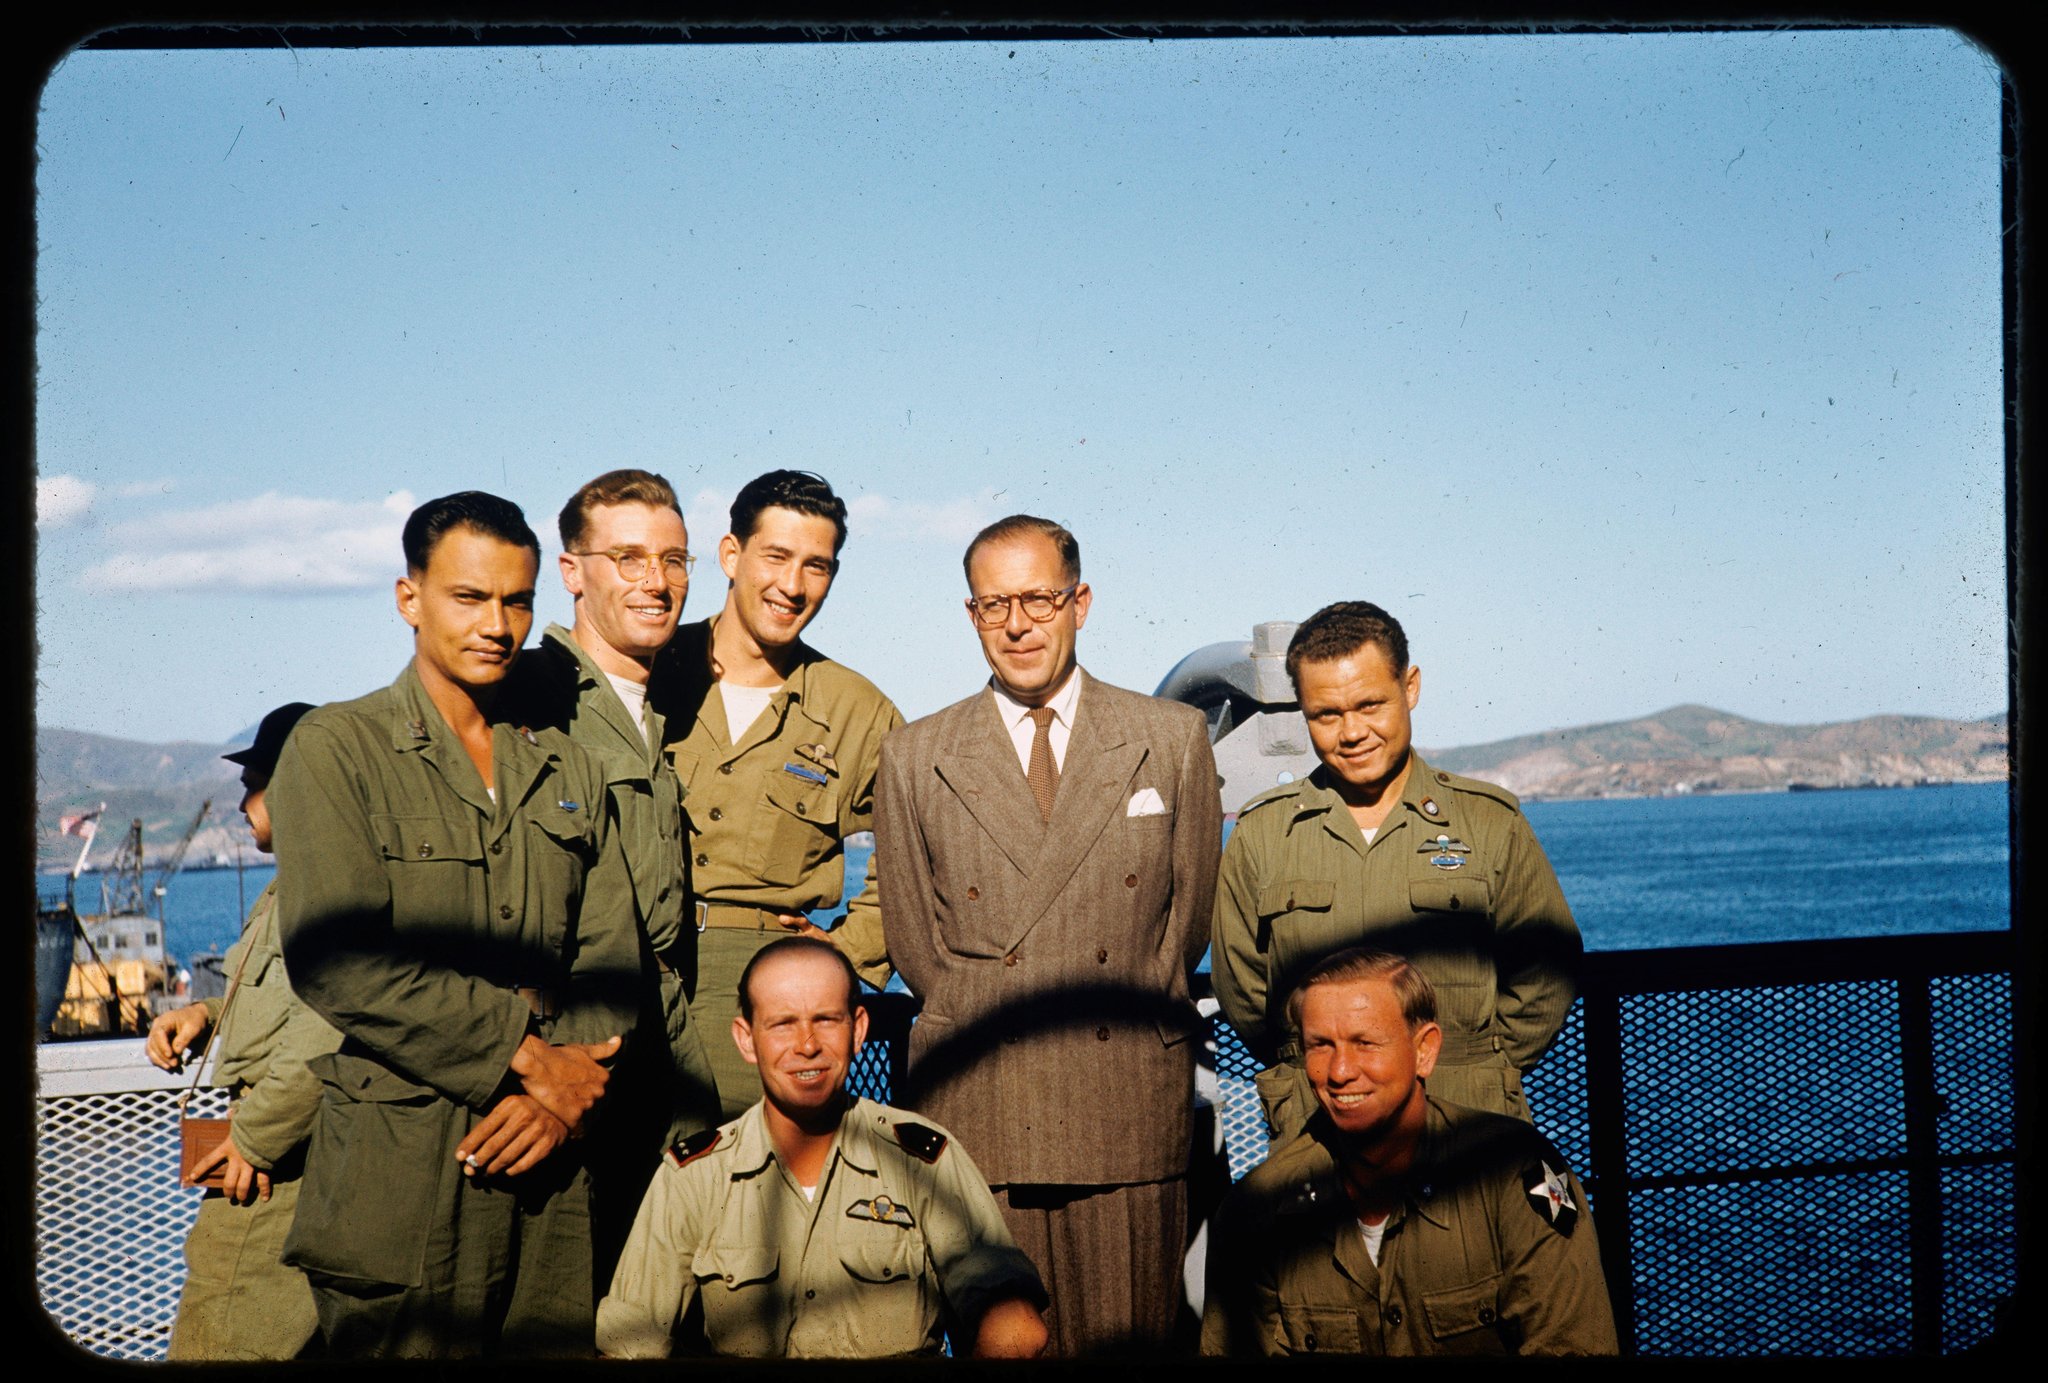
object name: color slide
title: Oorlog in Korea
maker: david ketel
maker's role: diplomaat, sinoloog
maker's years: 1913-2008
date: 1951-1953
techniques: slide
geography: korea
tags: united nations, switzerland, david ketel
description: De man in het beige pak met bril is de heer David Ketel.